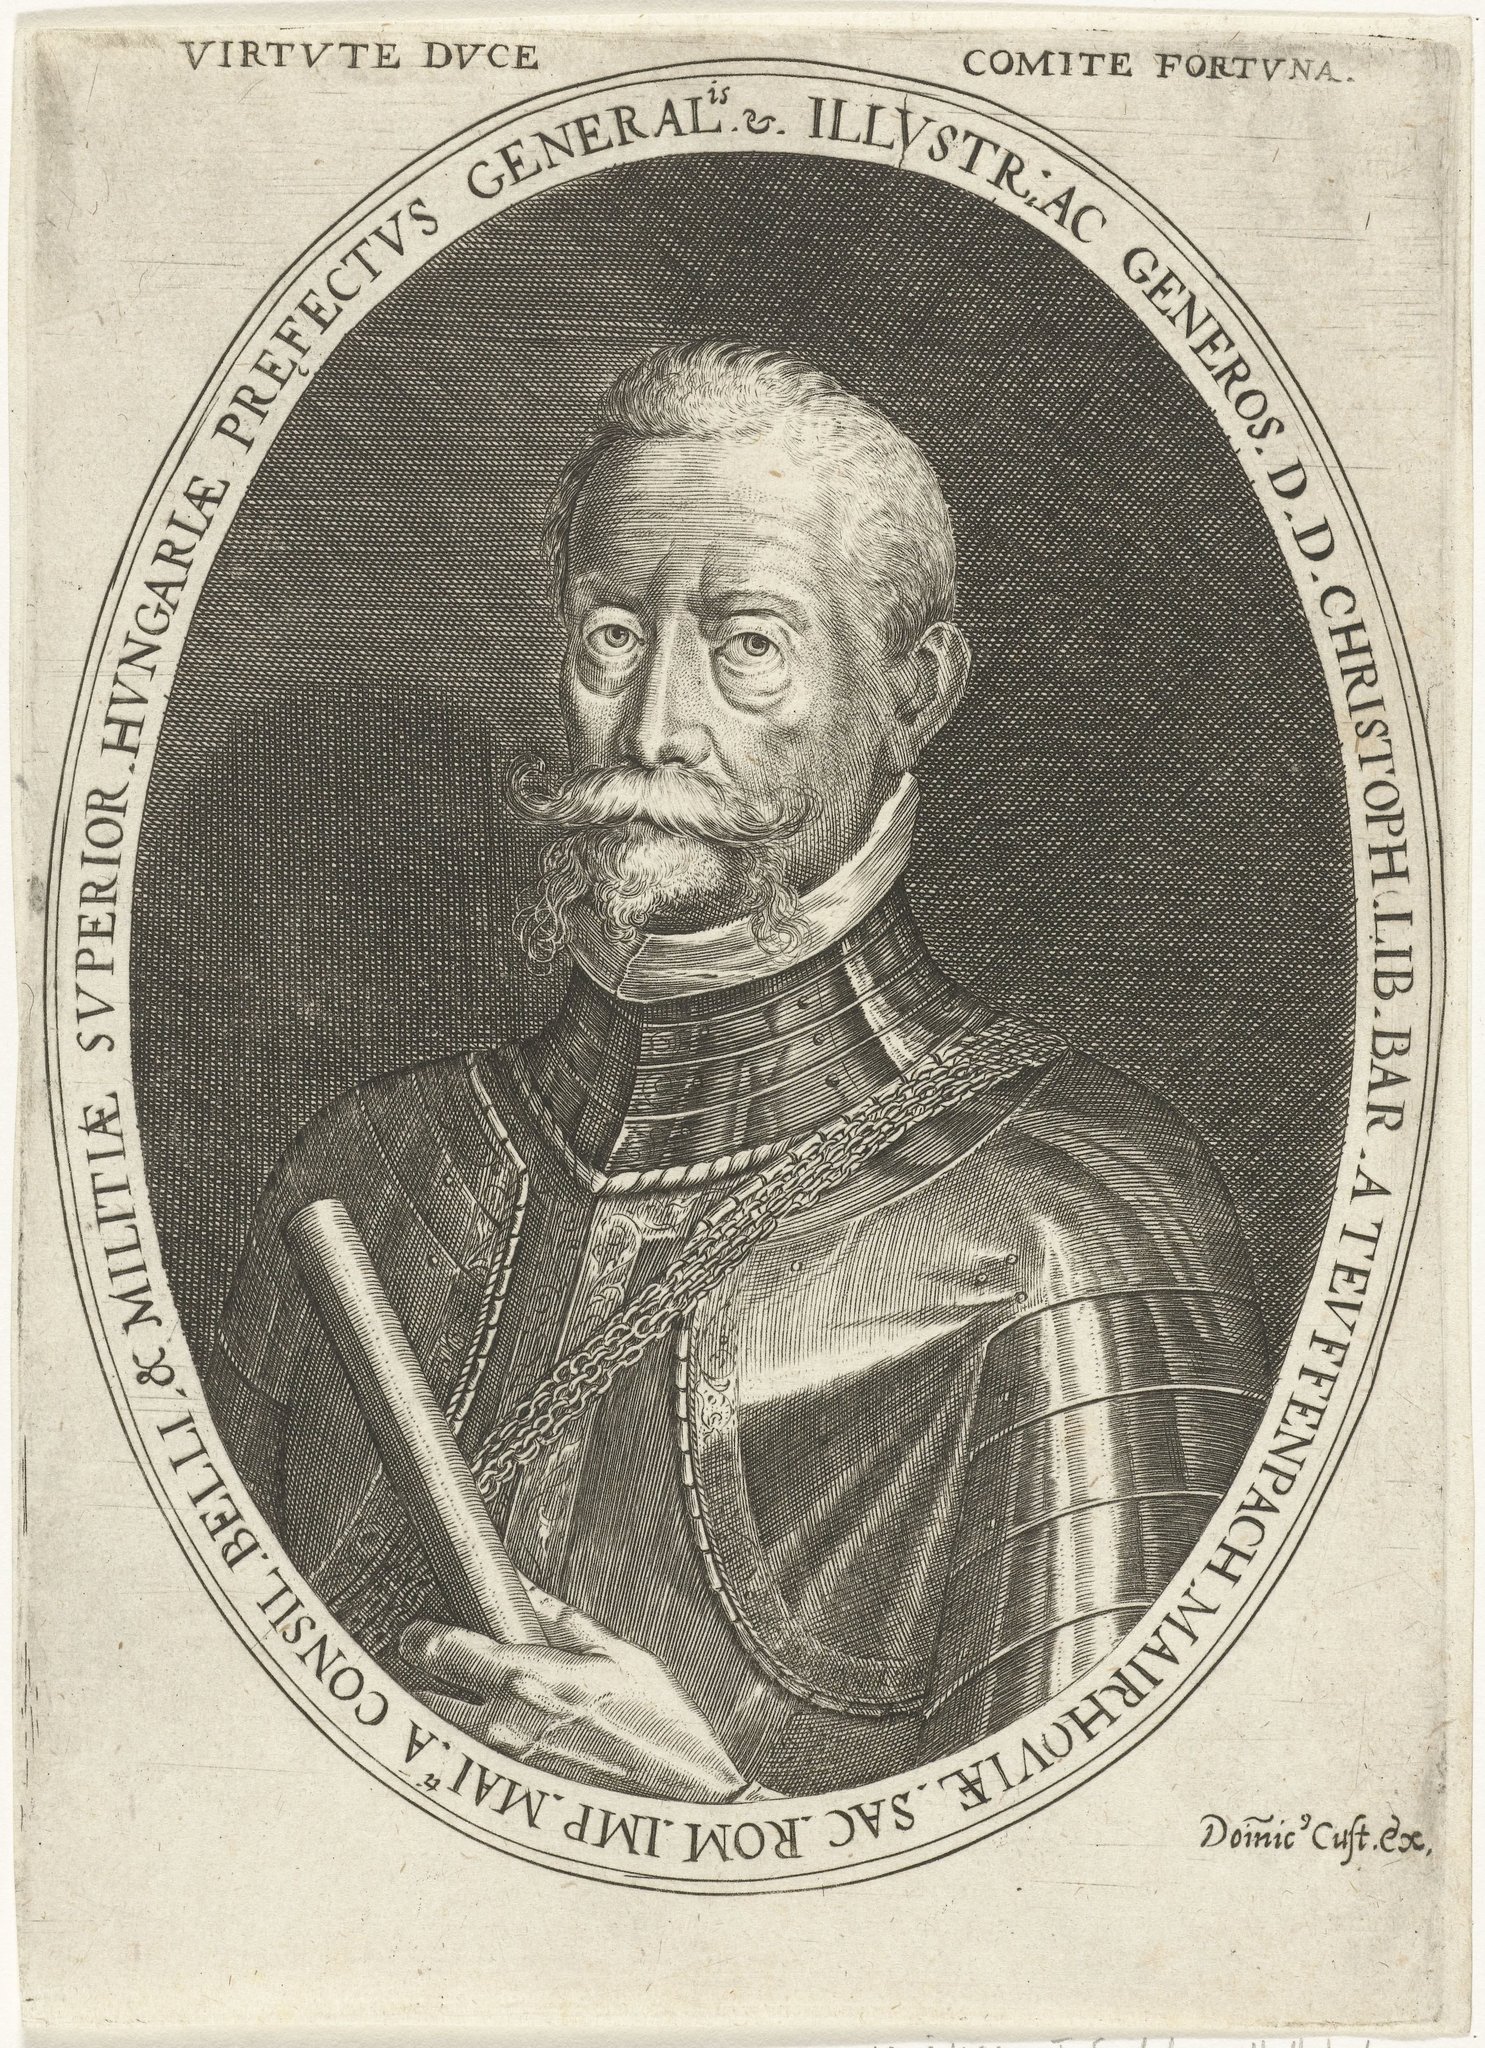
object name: print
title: Portret van Christoph Vrijheer van Teuffenbach-Mayrhofen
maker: dominicus custos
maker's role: print maker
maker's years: 1560-1615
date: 1600-1604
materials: paper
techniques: engraving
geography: augsburg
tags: christoph vrijheer van teuffenbach-mayrhofen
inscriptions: collector's mark: Lugt 2228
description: Illustratie uit: D. Custos en M. Henning. Atrium heroicum Caesarum, regum aliorq. summatum ac procerum qui intra proximum seculum vixere, aut hodie supersunt, imaginib. Deel 1-4. Augsburg: D. Custos, 1600-1604.